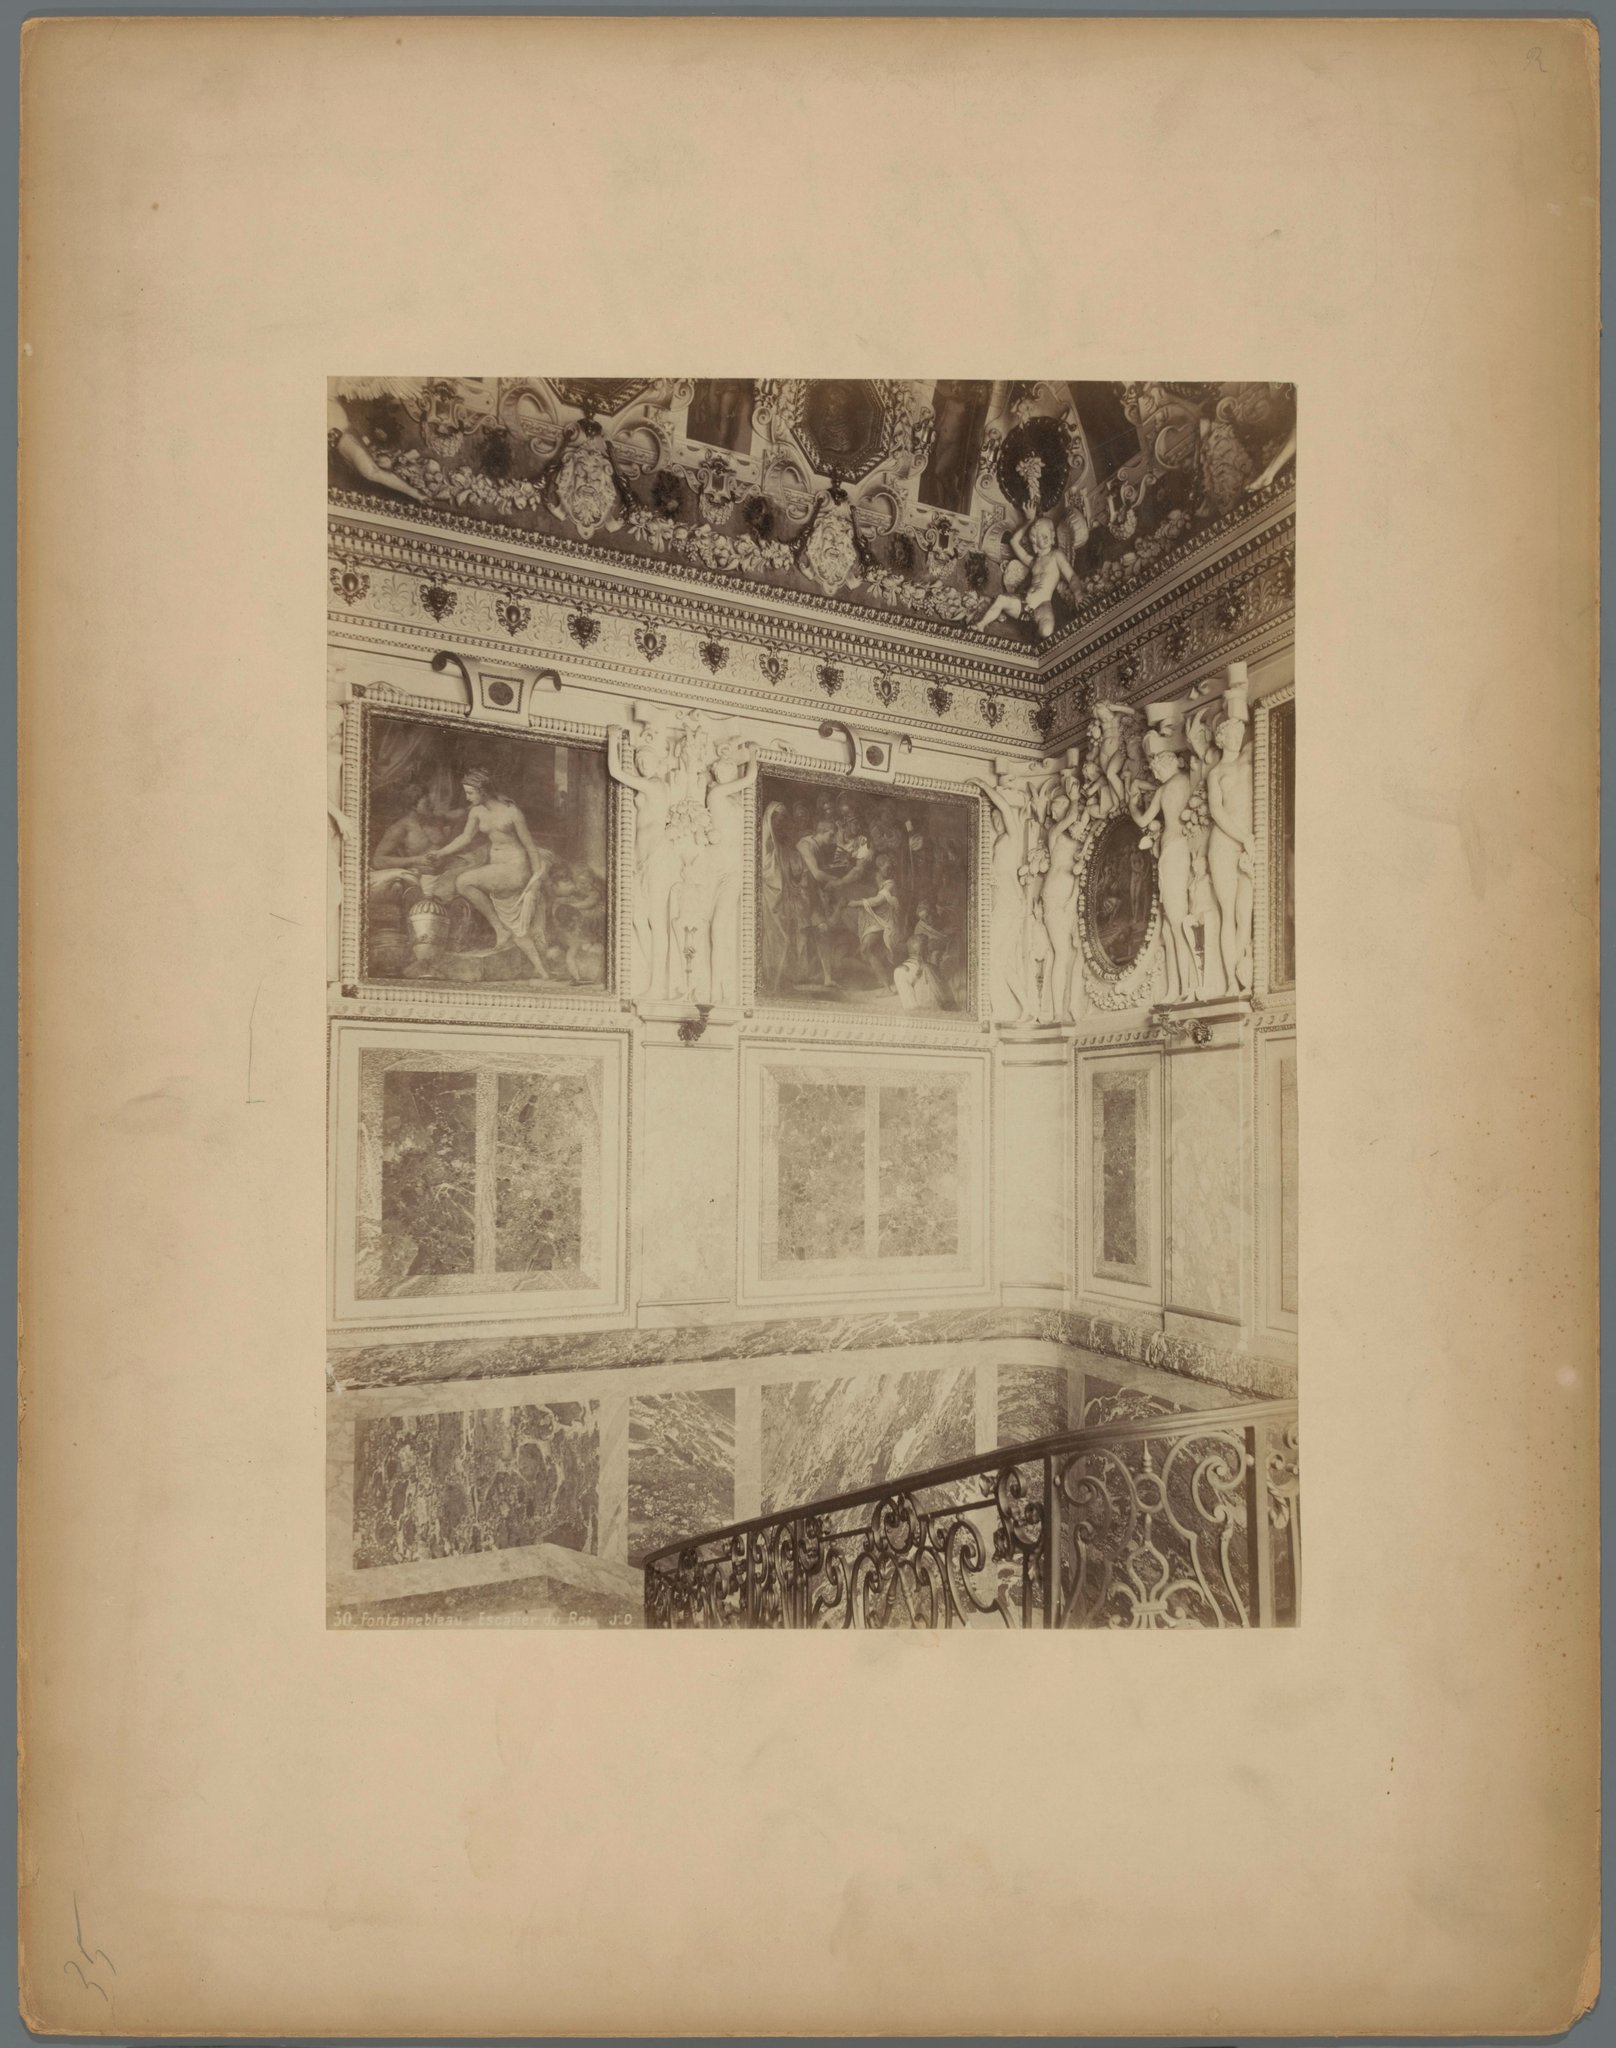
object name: photograph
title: Fontainebleau, - Chambre Napoléon 1er.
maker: jd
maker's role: fotograaf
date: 1875-1900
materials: cardboard, photographic support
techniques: albumen print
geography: fontainebleau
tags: palace, bed, interior ~ representation of a building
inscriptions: number: ‘17,’, collector's mark: Lugt 3937